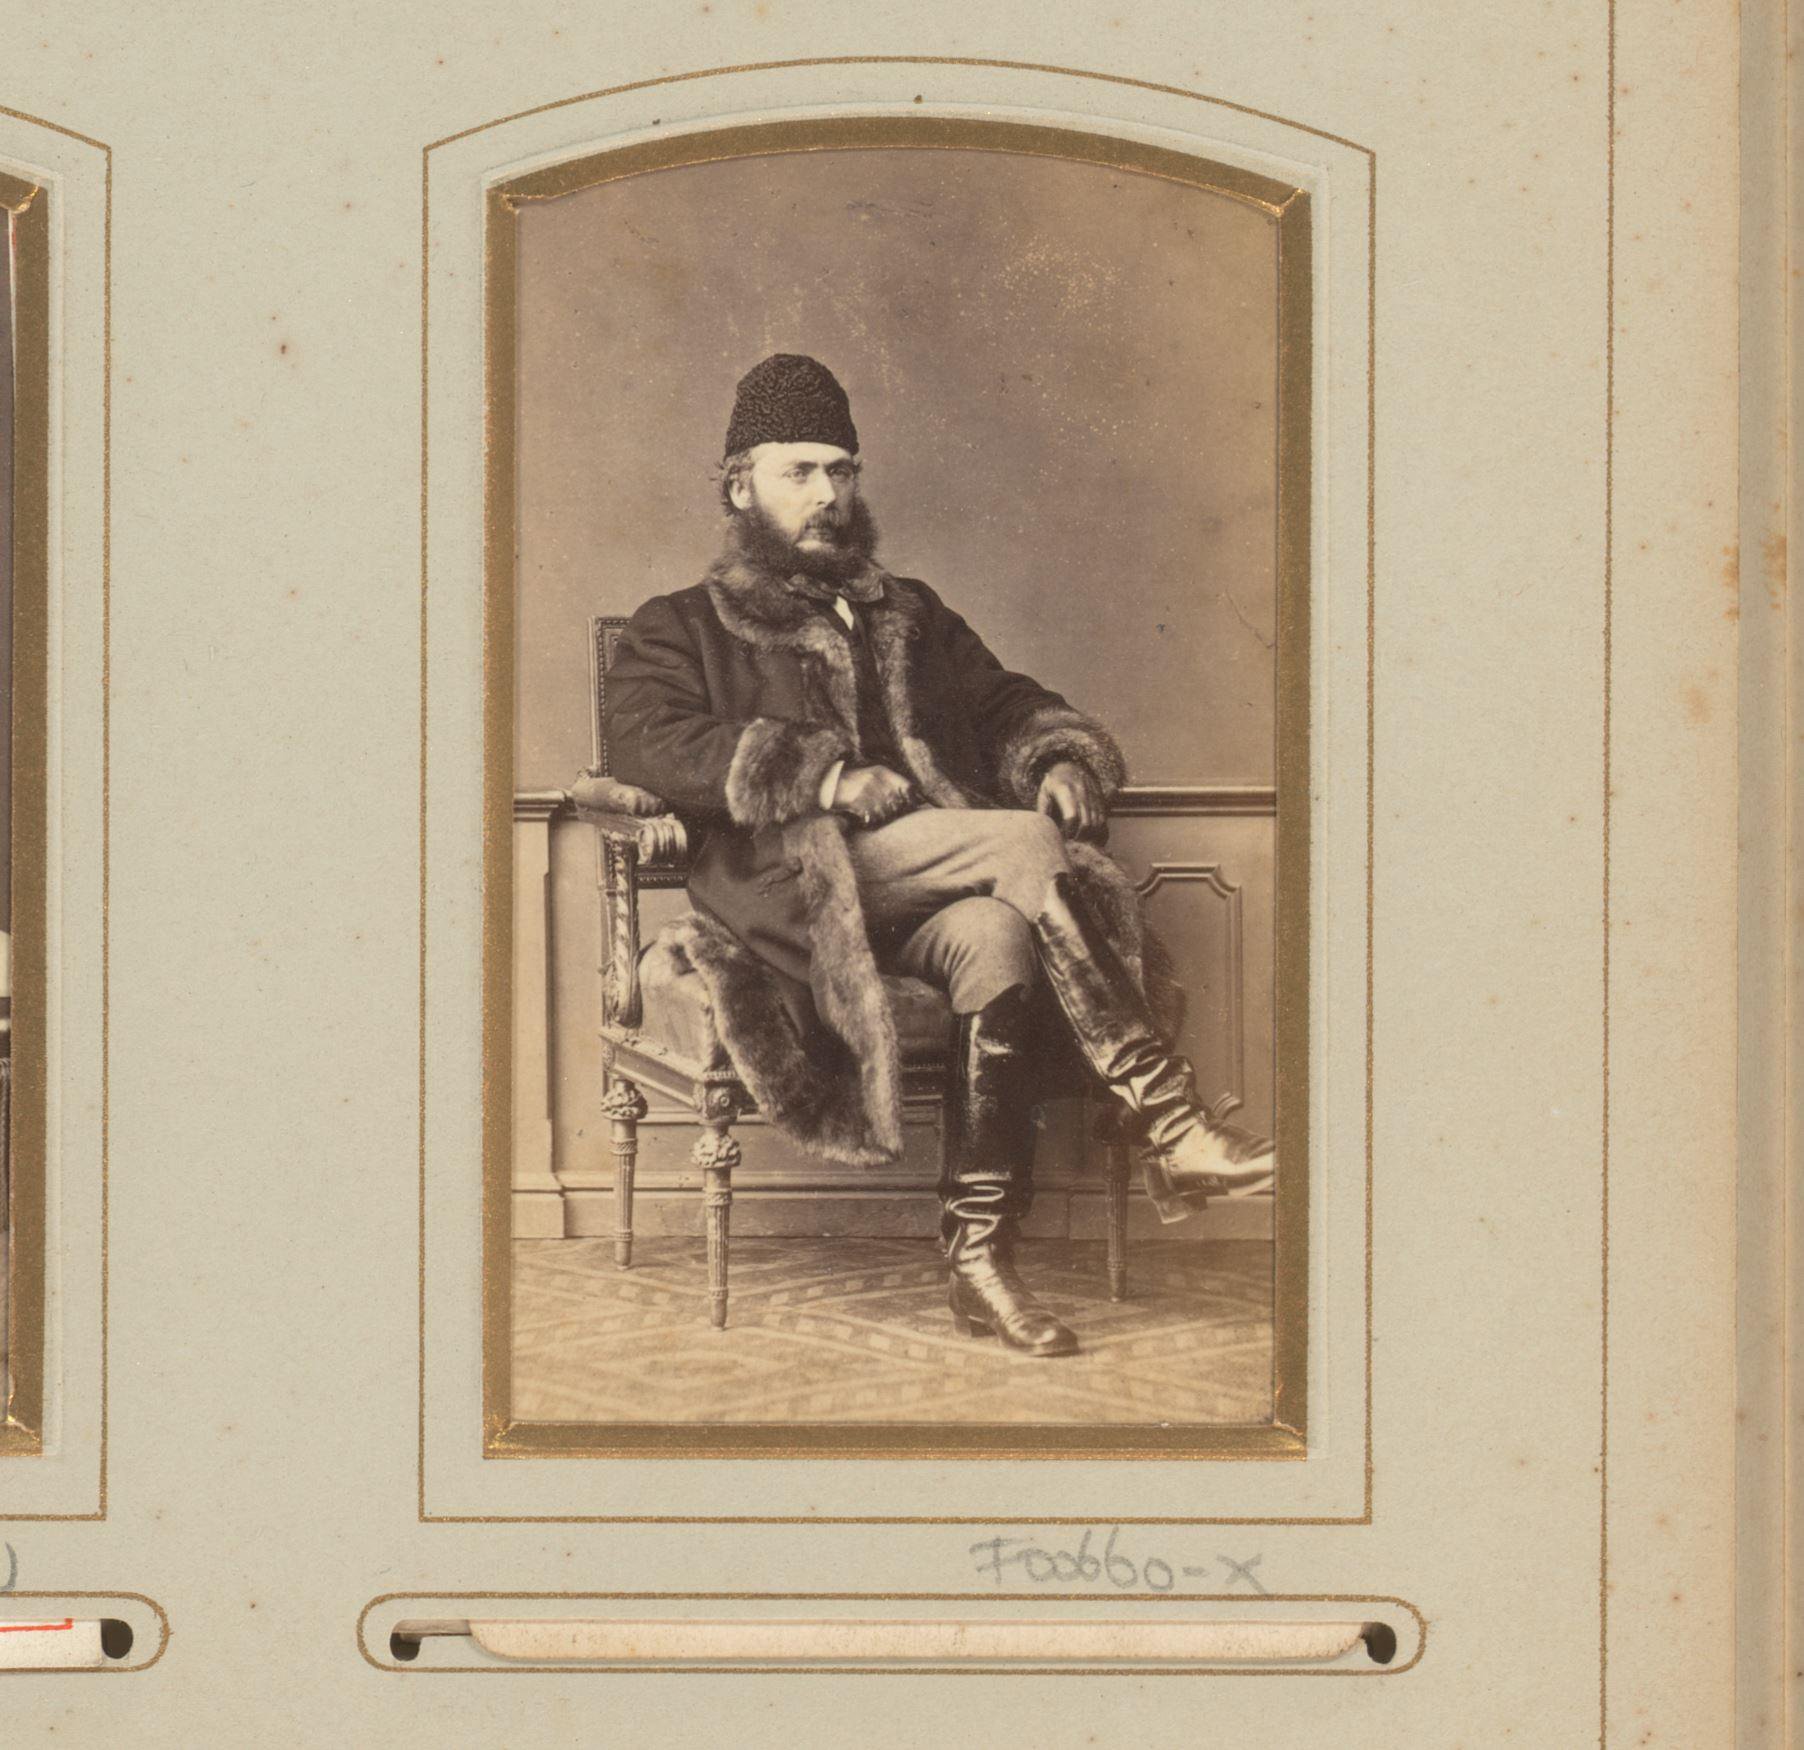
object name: album leaf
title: Portret van een zittende man met bontjas en bontmuts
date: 1850-1873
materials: cardboard, photographic support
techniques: albumen print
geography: budapest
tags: head-gear (with name), historical persons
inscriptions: inscription: ‘BORSOS és DOCTOR/ Országut 42. Sz./ VOLT BOTÁNIKUS KERTBEN/ PESTEN.’, number: ‘17944’